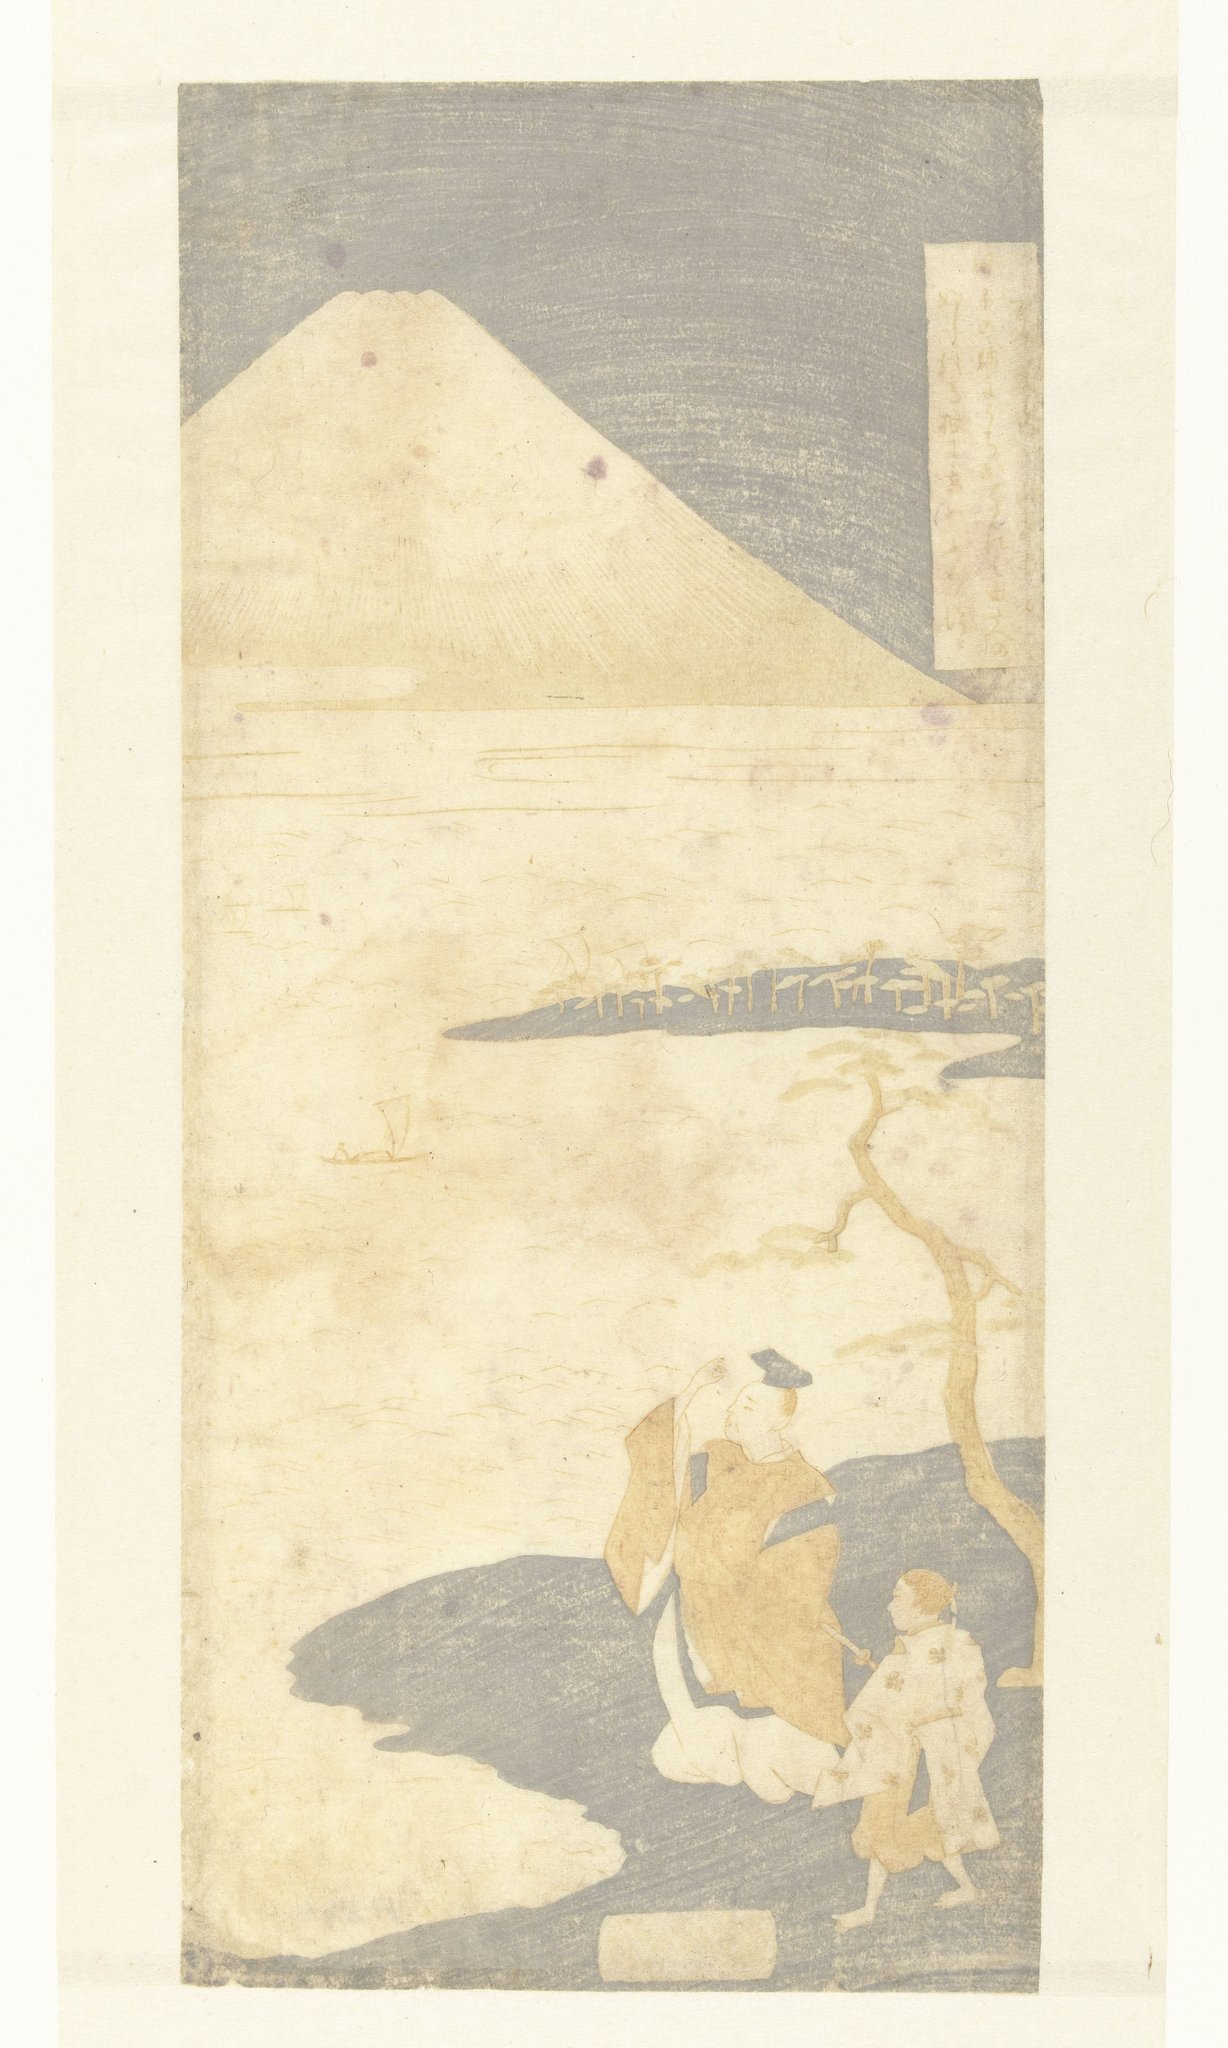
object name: print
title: De dichter Yamabe no Akahito kijkend naar de berg Fuji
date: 1761-1765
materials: paper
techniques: woodcut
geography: japan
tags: writer, poet, author, trees: pine, mountains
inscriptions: inscription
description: Man in Heian hofkleding (Yamabe no Akahito) staand met jonge dienaar op strand, onder pijnboom, opkijkend naar de berg Fuji.